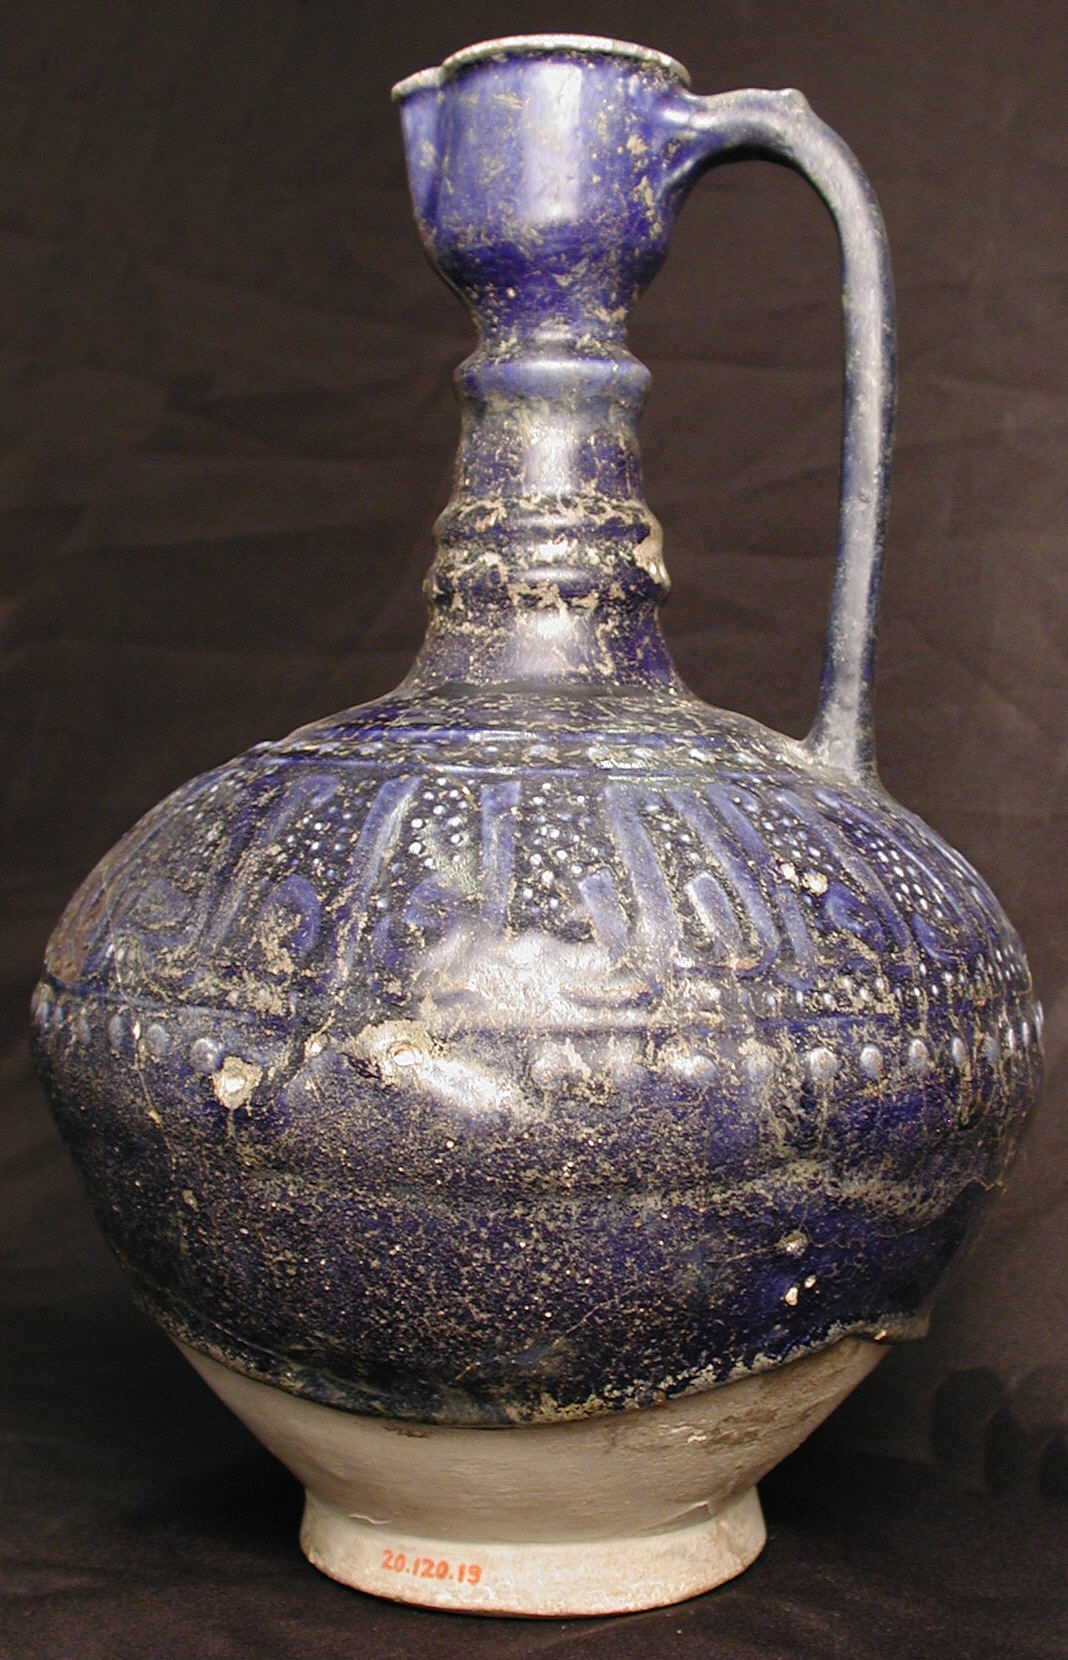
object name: ewer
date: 1101-1300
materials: stonepaste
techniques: glazing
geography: iran